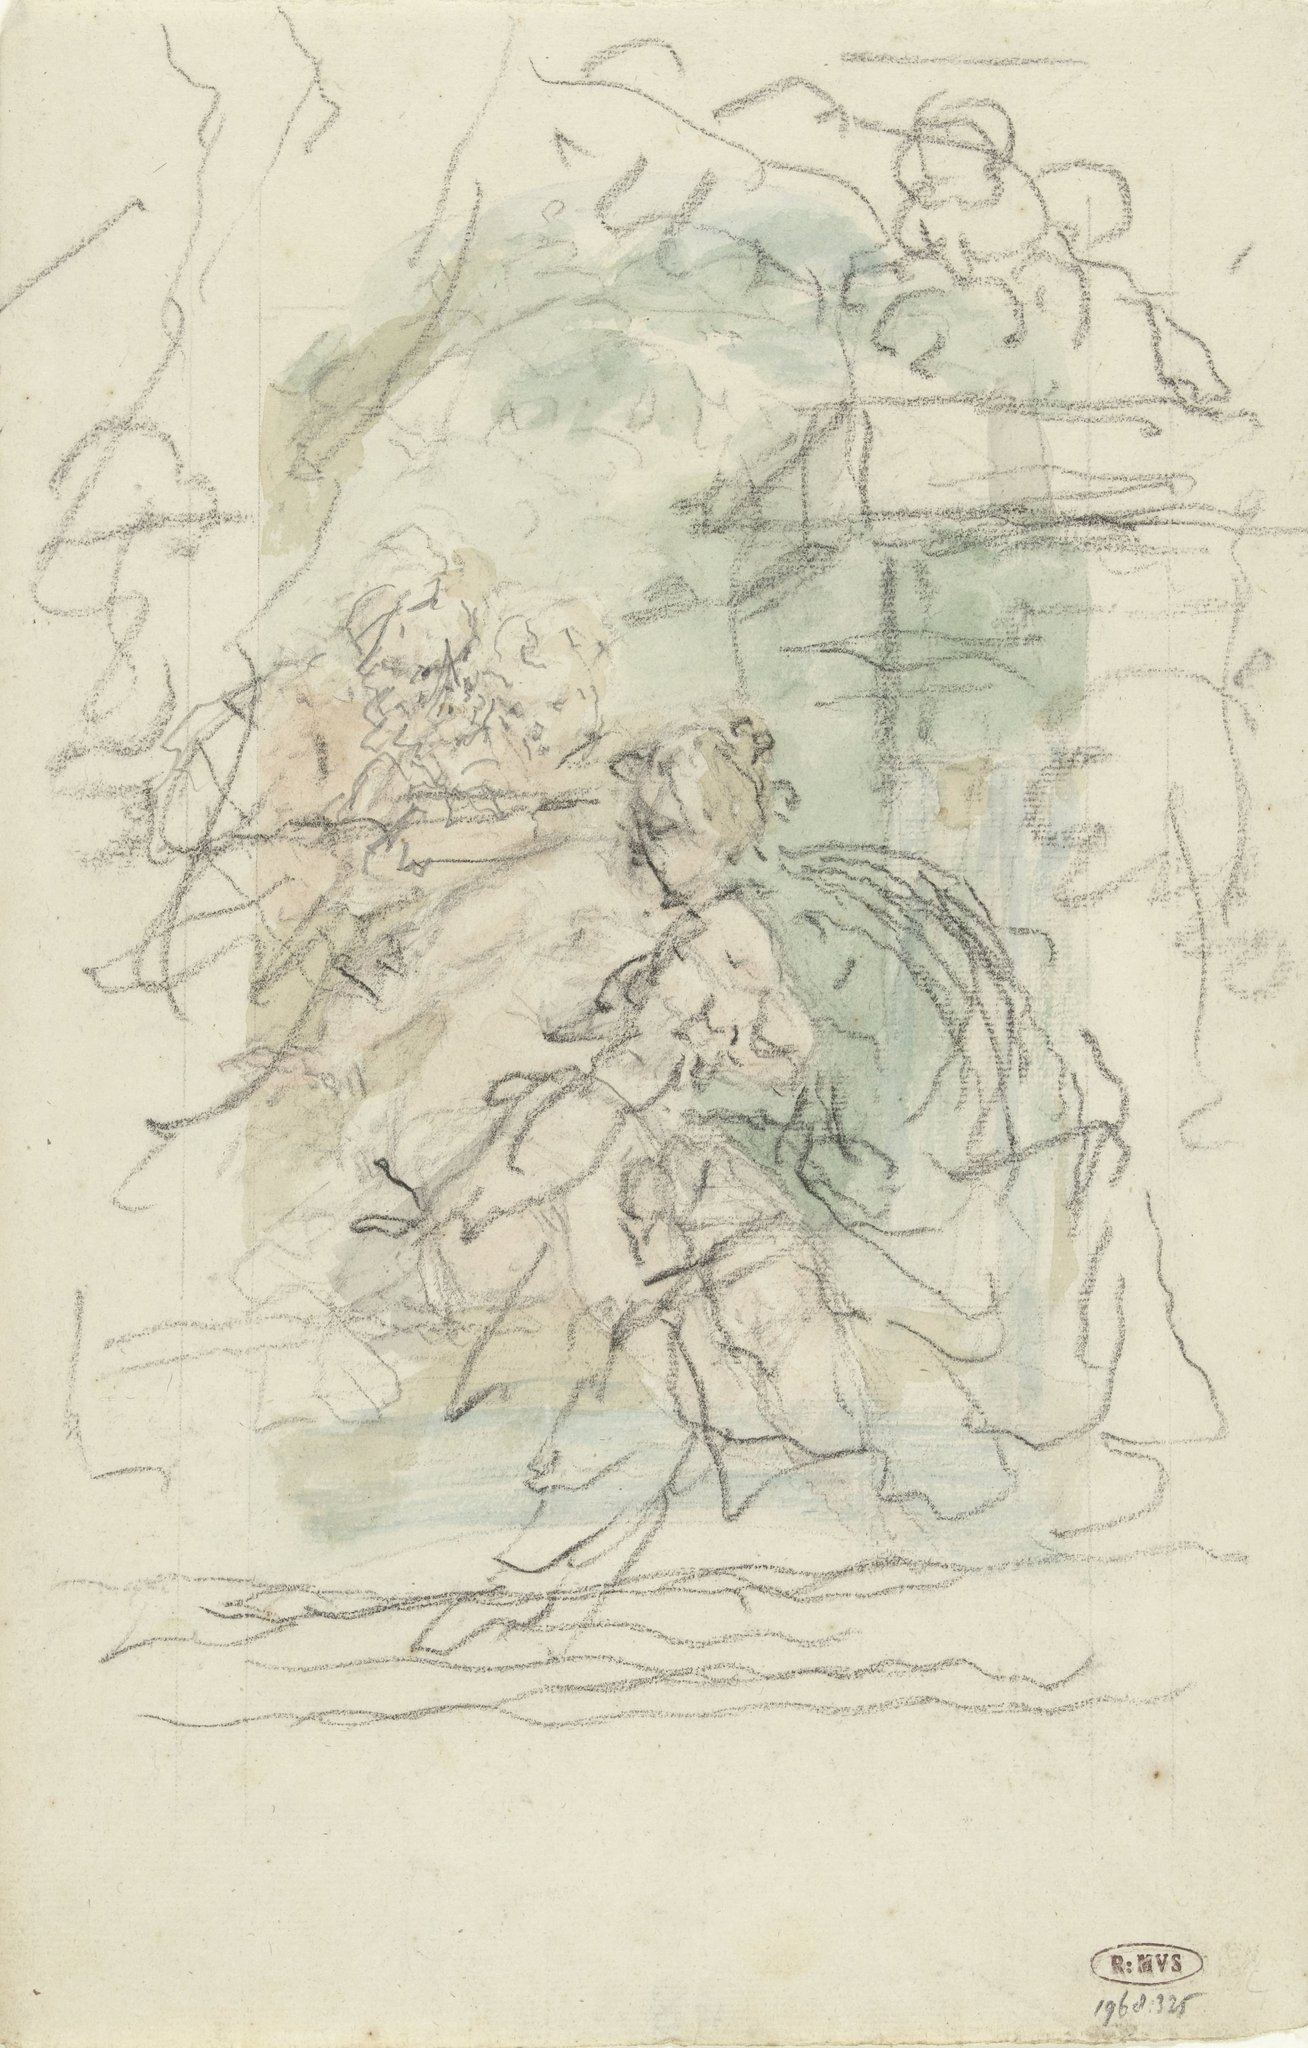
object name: design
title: Ontwerp voor decoratief paneel met Suzanna en de Ouderlingen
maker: dionys van nijmegen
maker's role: draughtsman, painter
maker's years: 1705-1798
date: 1715-1798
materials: chalk, paper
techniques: brush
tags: the elders spying upon susanna